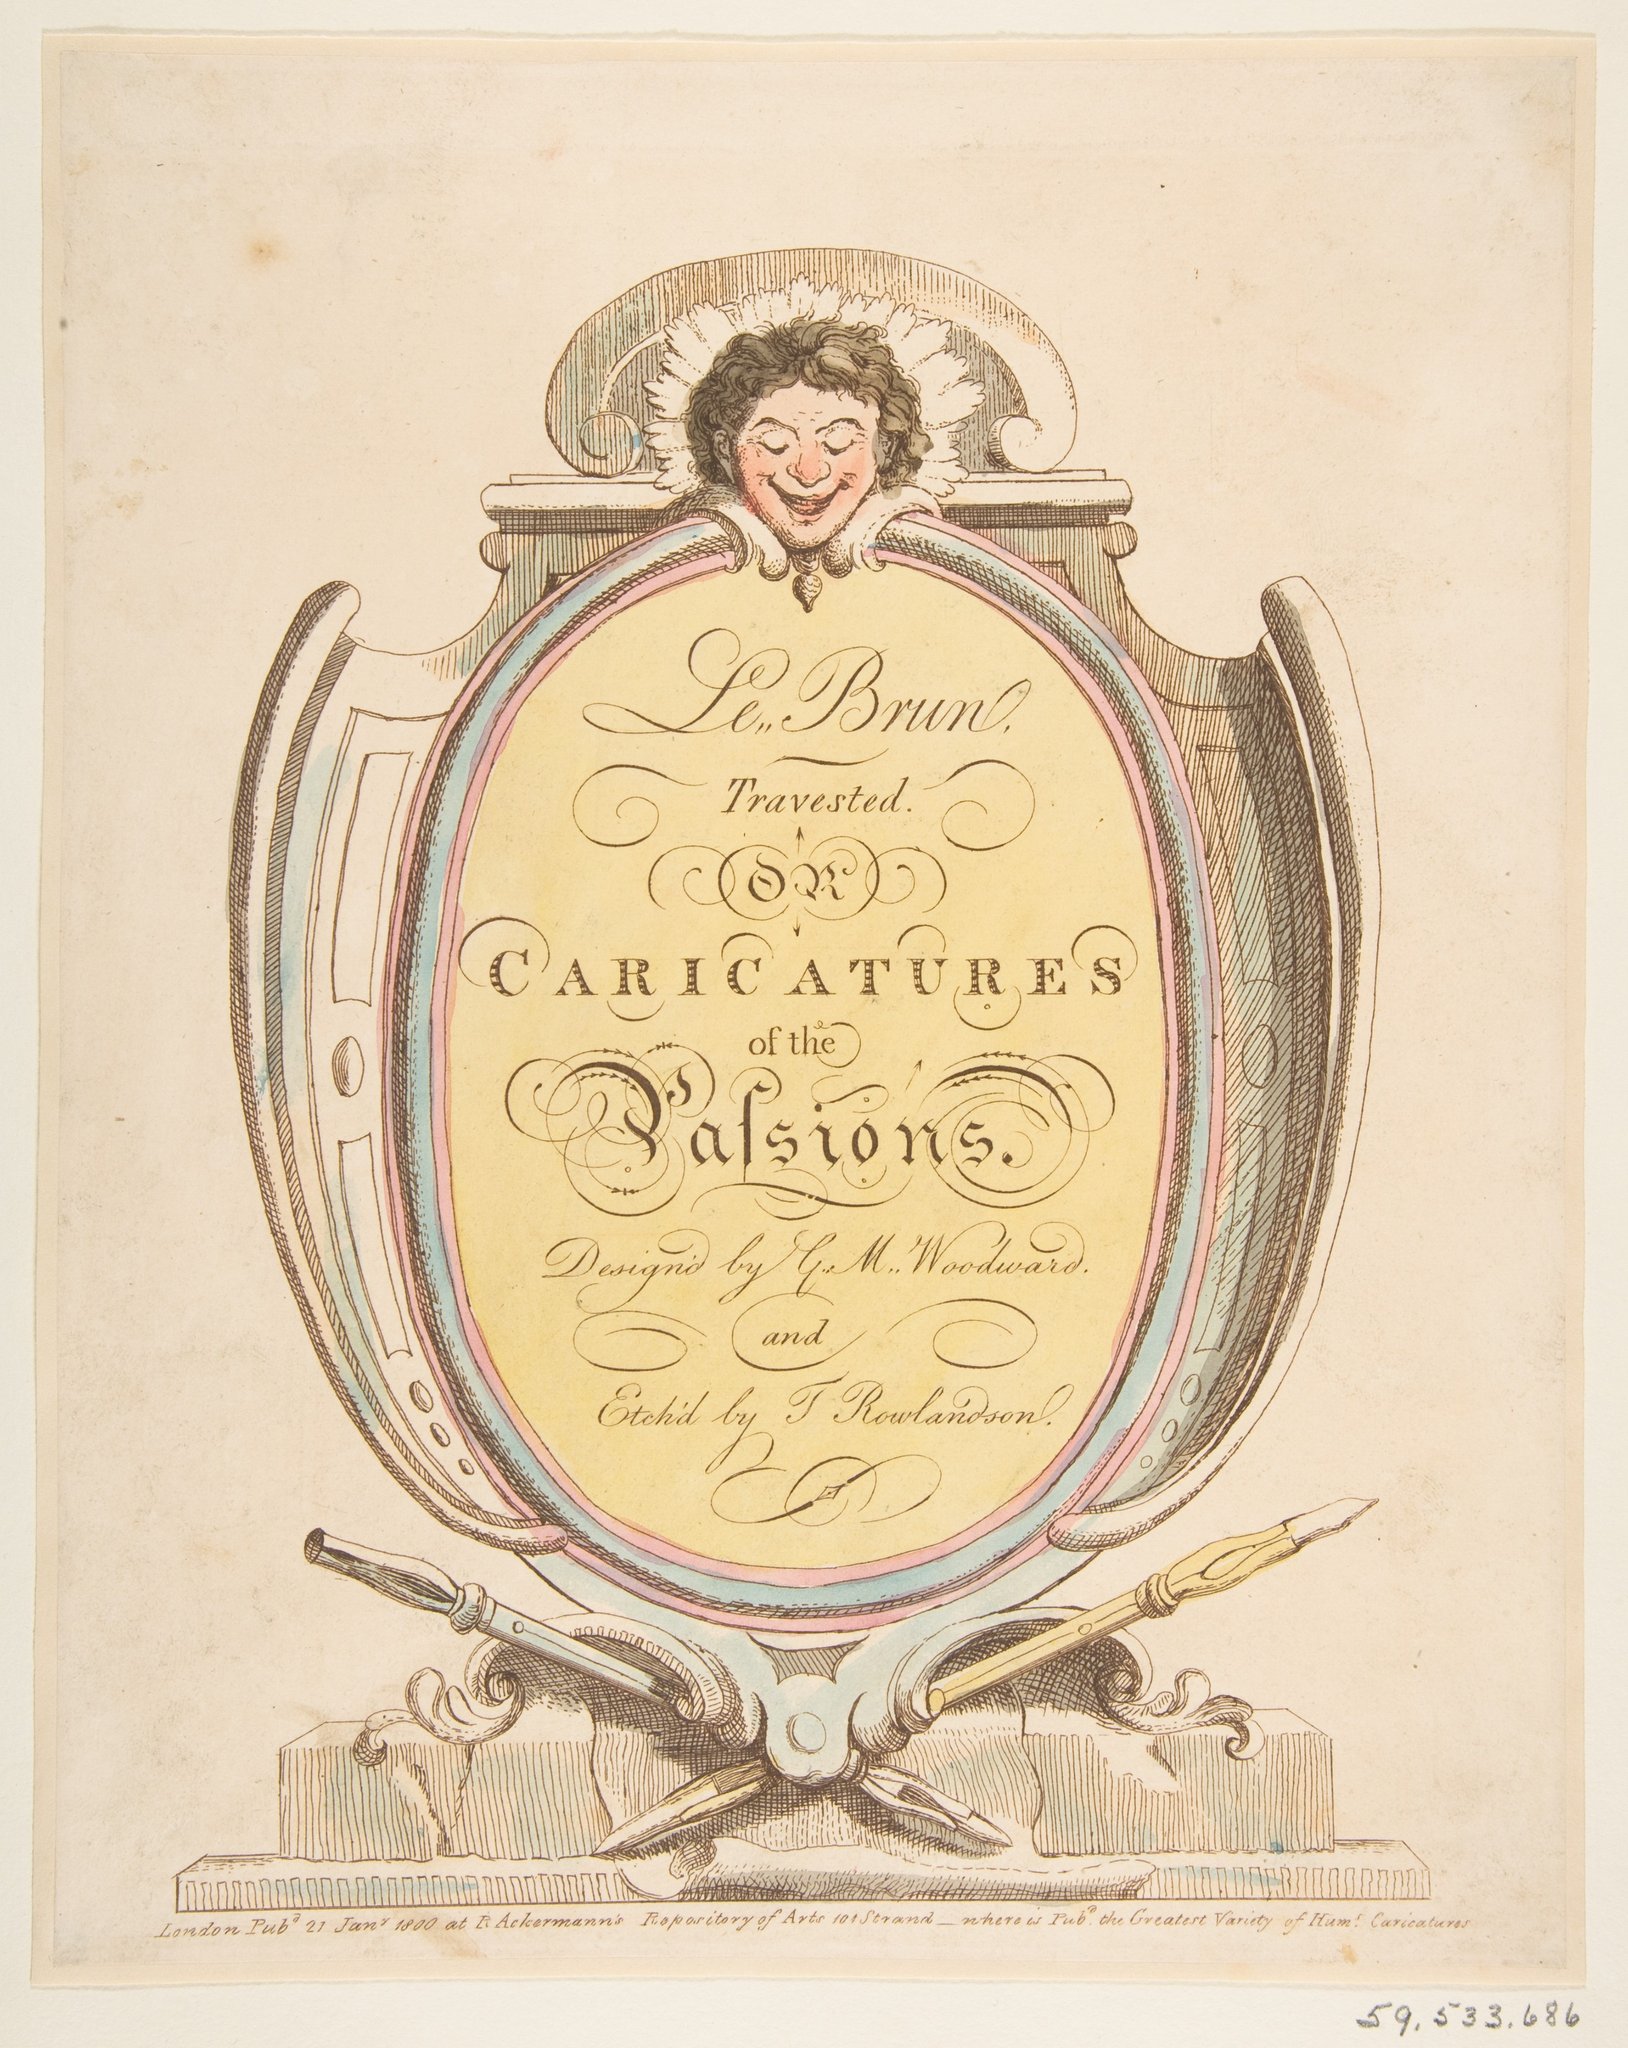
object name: print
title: Title Page: Le Brun Travested, or Caricatures of the Passions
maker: thomas rowlandson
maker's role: artist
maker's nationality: british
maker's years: 1757-1827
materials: ink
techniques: etching, hand coloring, printing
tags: satire,faces